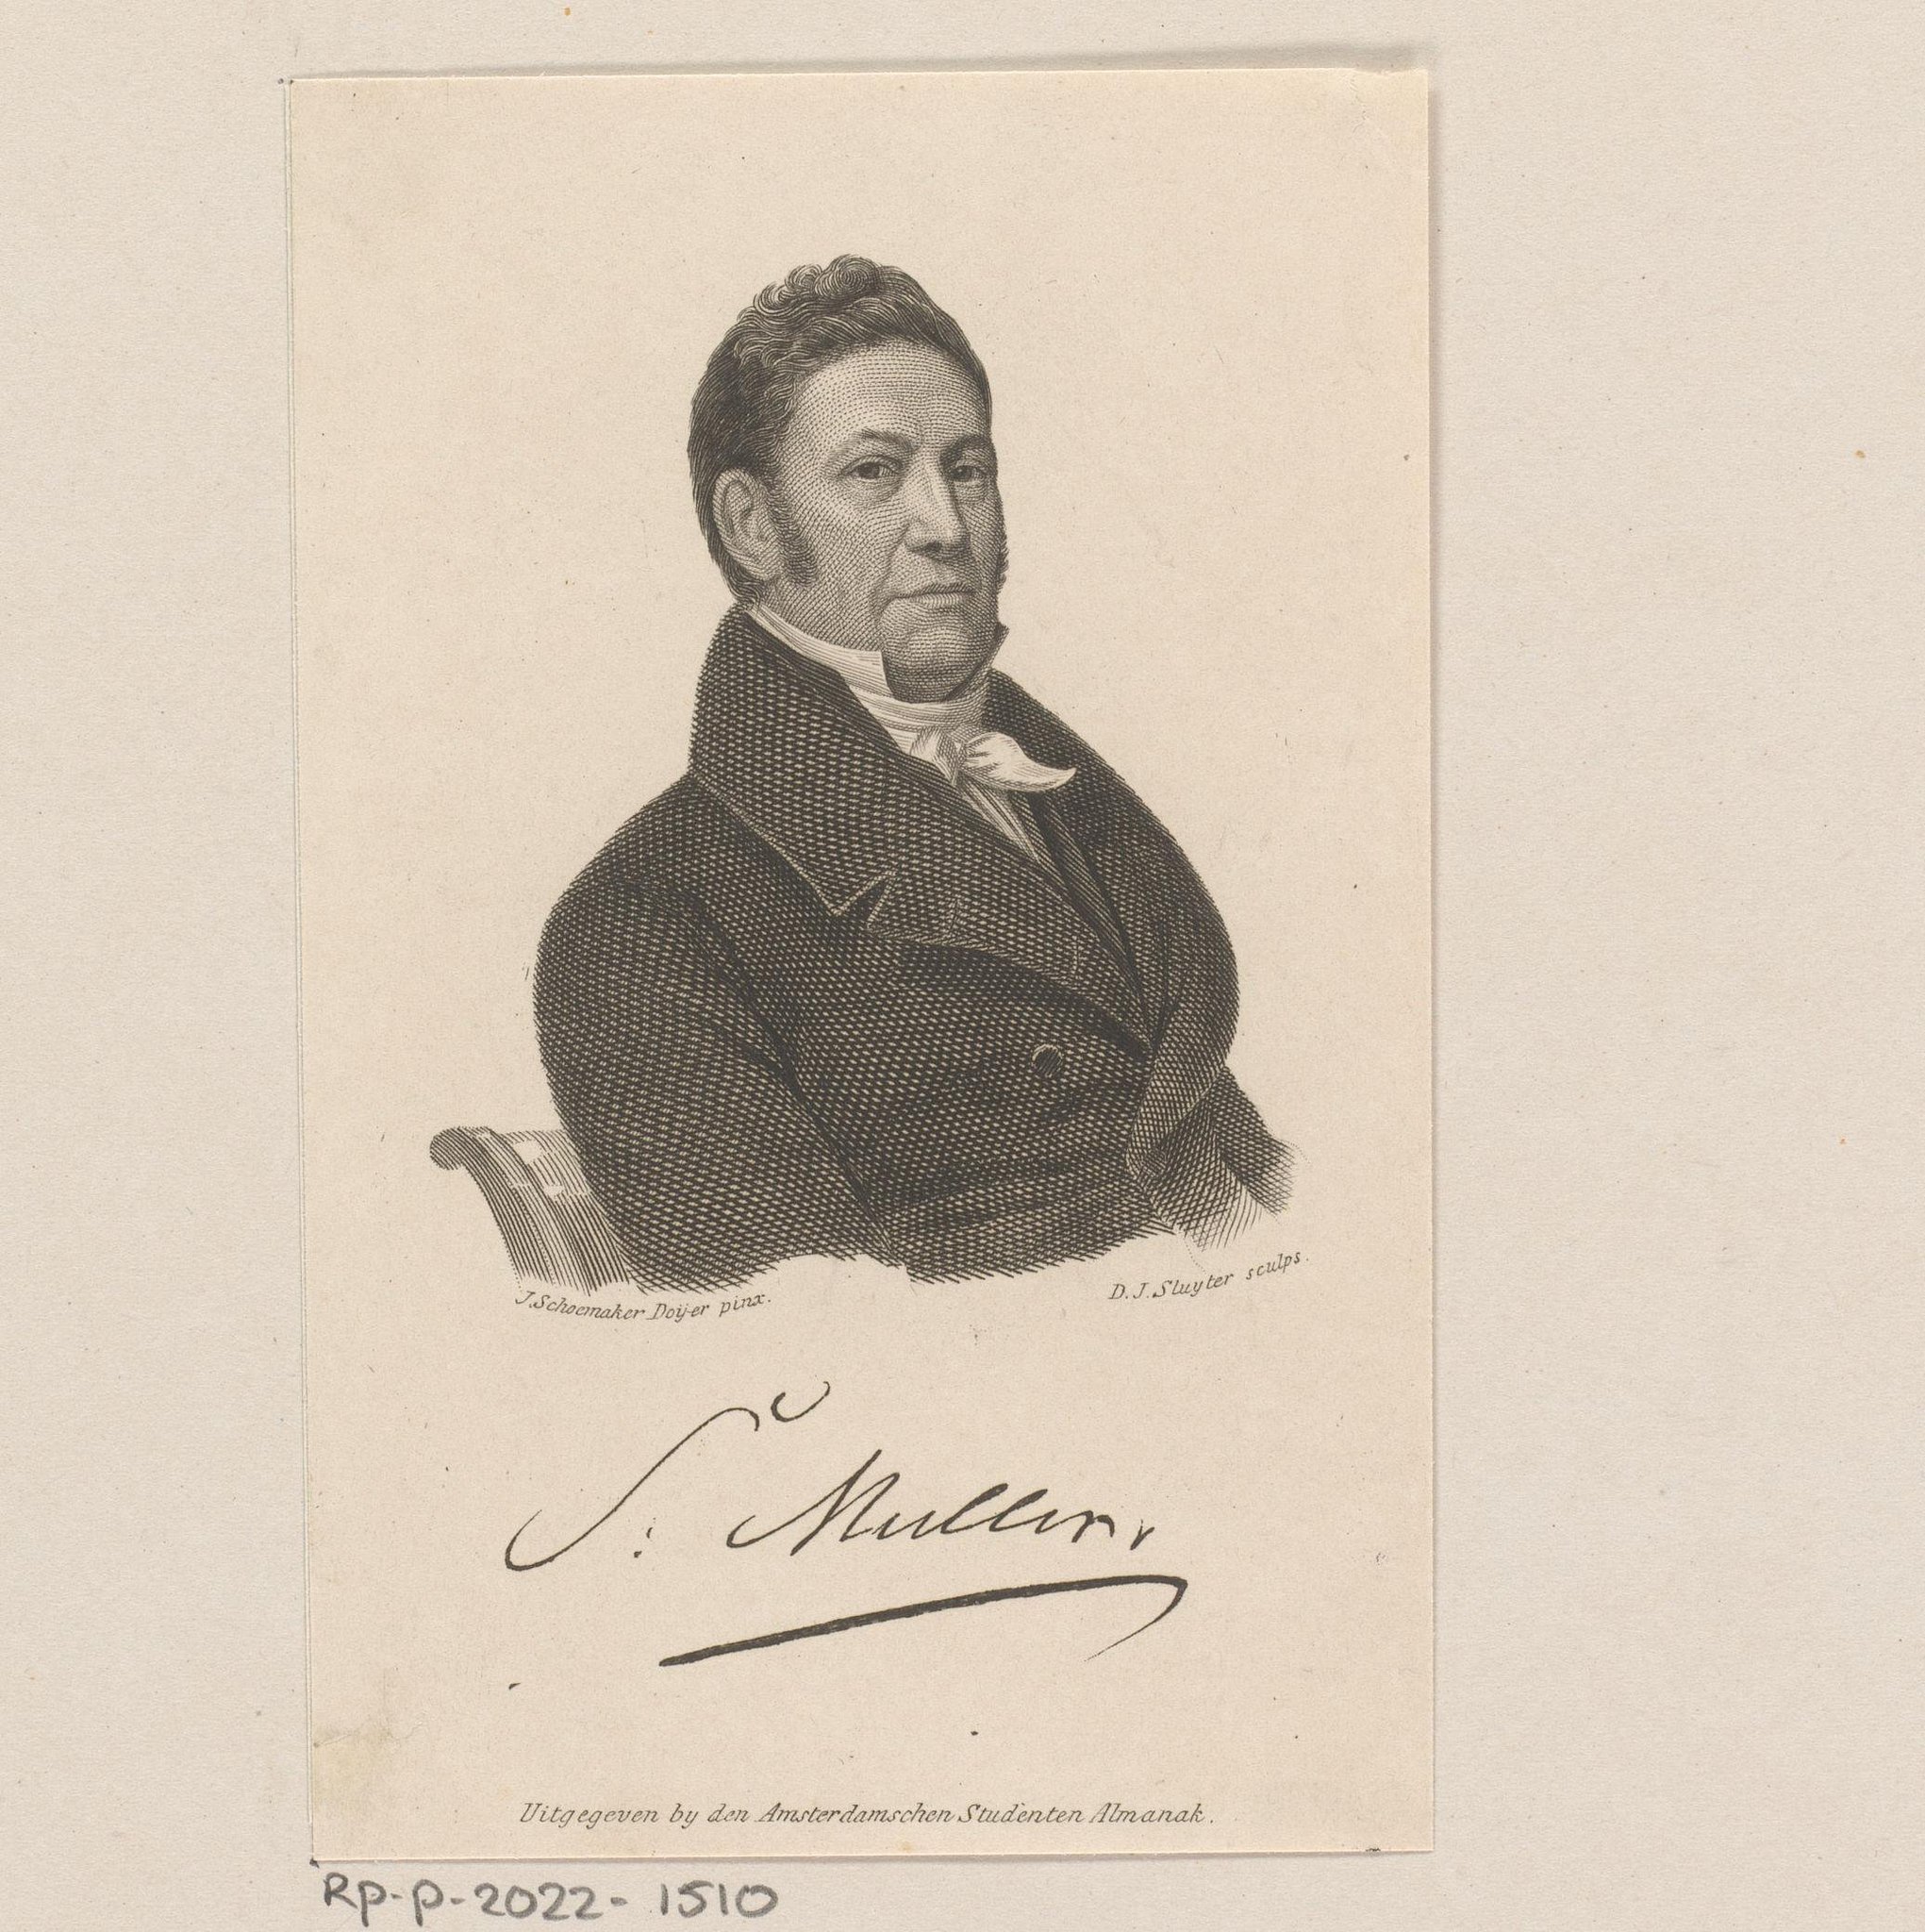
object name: print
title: Portret van Samuel Muller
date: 1845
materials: paper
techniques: etching, engraving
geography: amsterdam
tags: amsterdam, samuel muller (1785-1875), higher education, e.g.: teacher's college, historical persons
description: Prent waarschijnlijk uit: Amsterdamsche Studentenalmanak, 15 (1845).